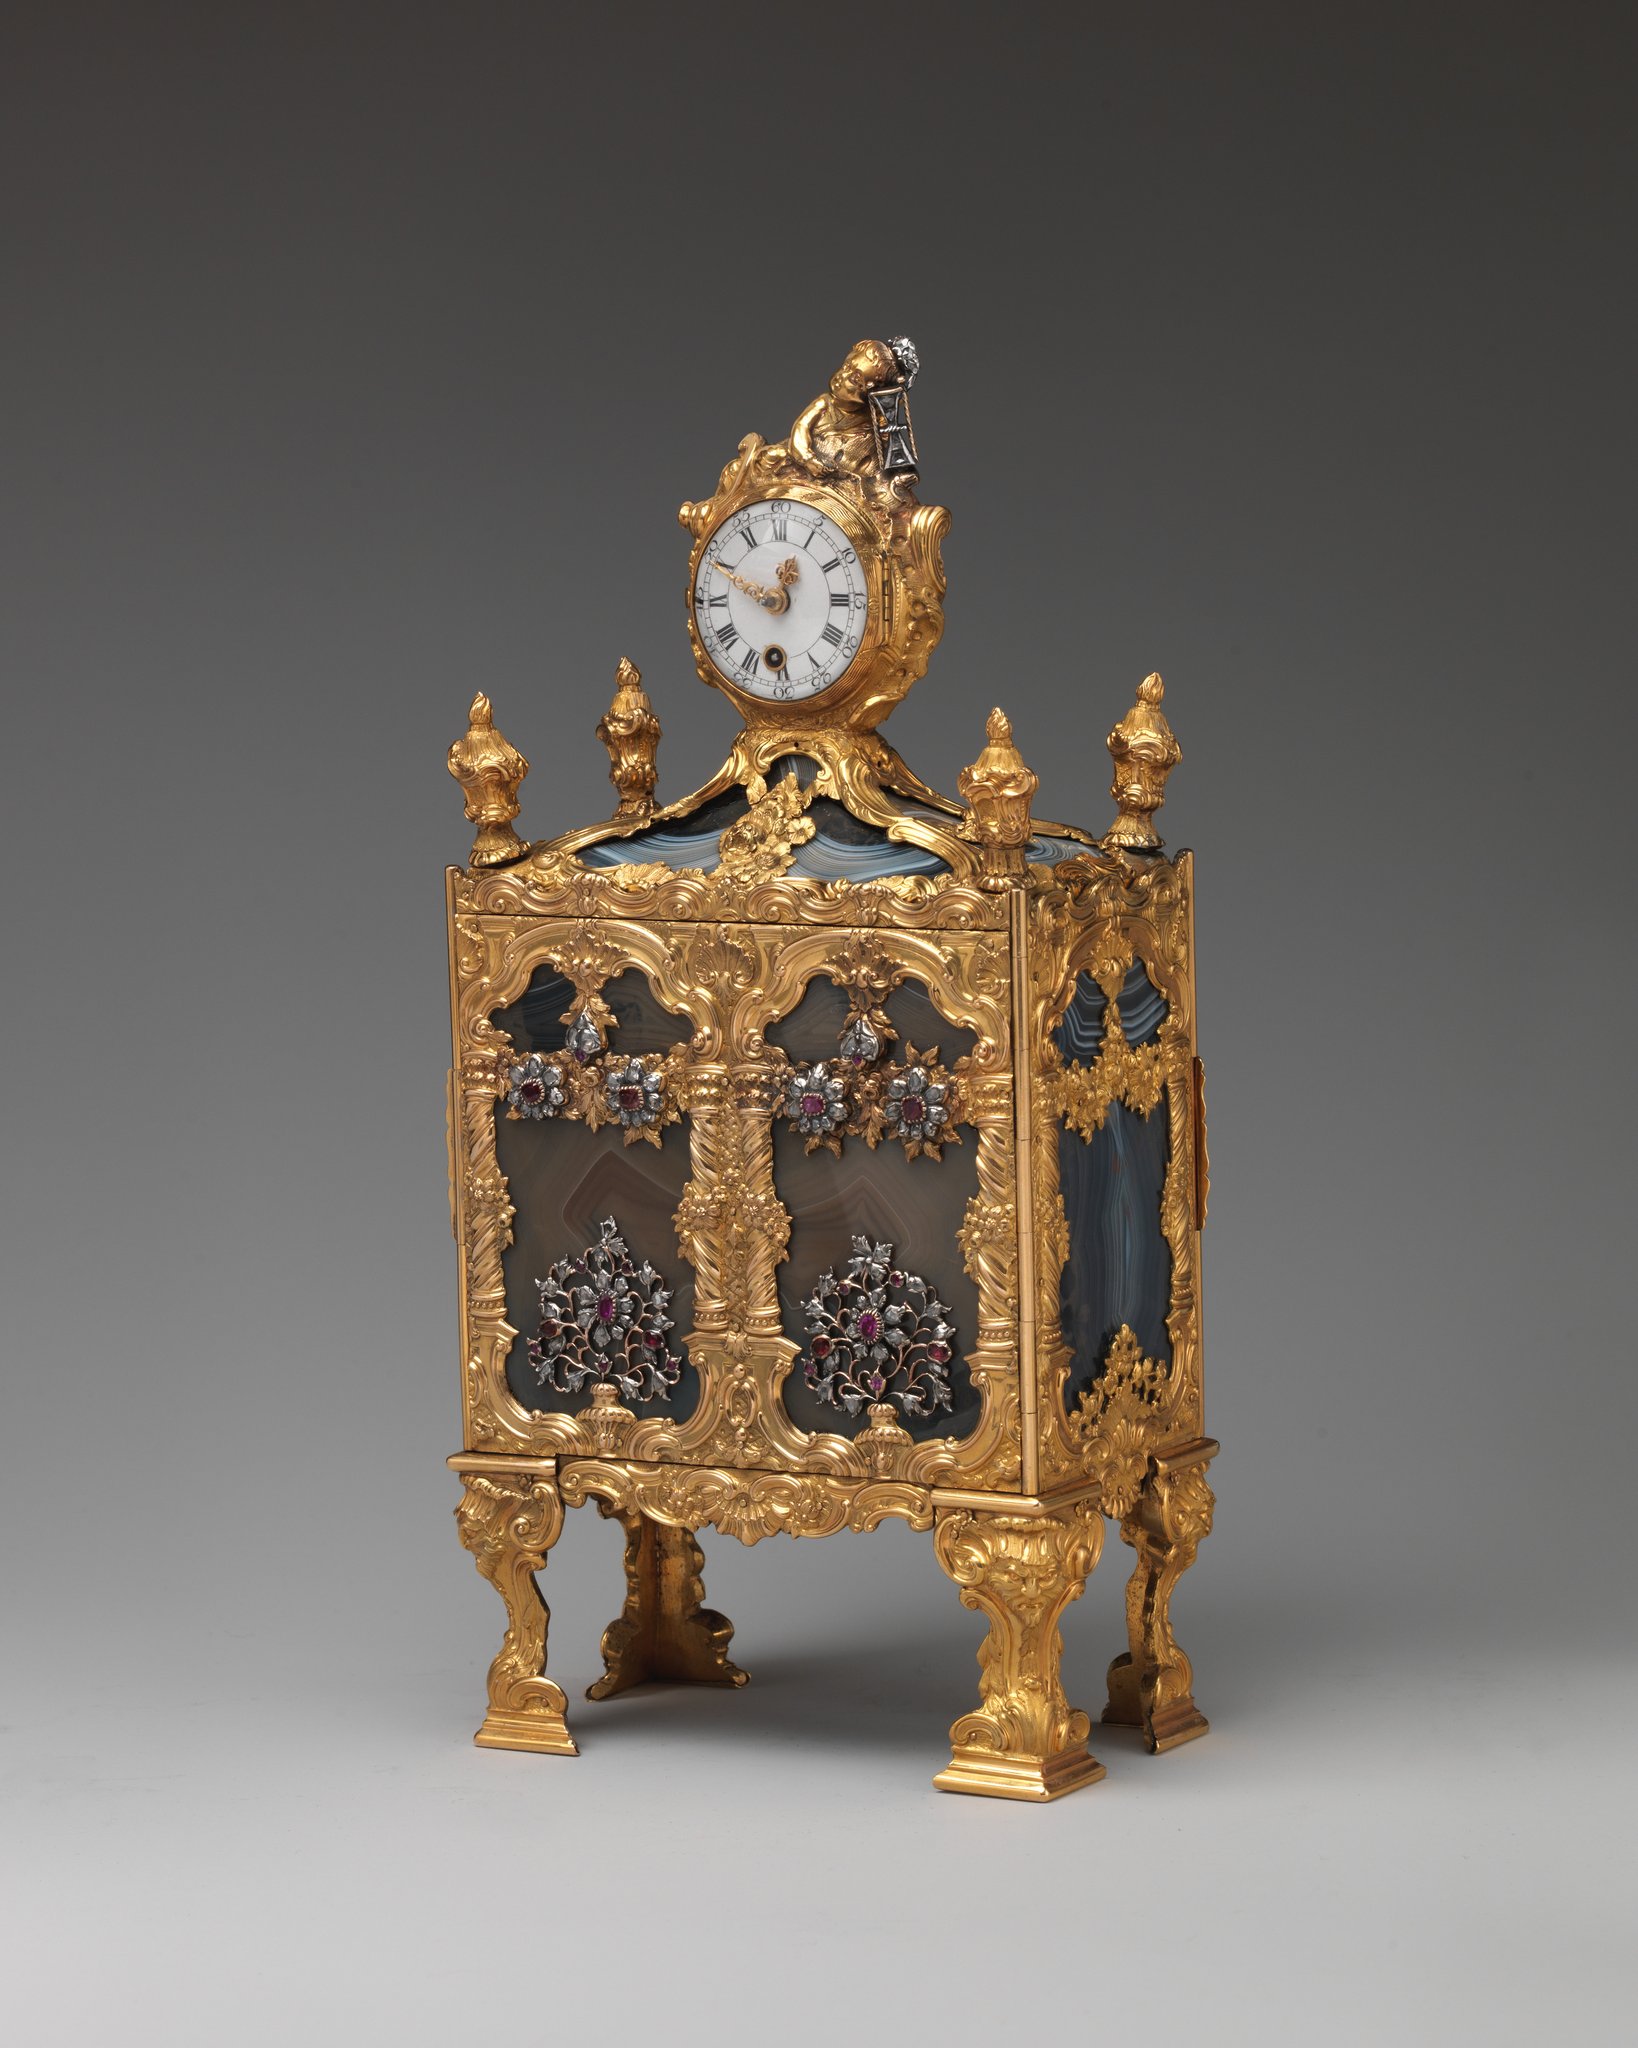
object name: nécessaire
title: Nécessaire (one of a pair)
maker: john barbot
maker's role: entrepreneur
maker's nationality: british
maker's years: 1751-1765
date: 1760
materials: stone, brass, diamond, enamel, gilt brass, gilt, glass, gold, gemstone, silk, silver, steel, velvet, wood